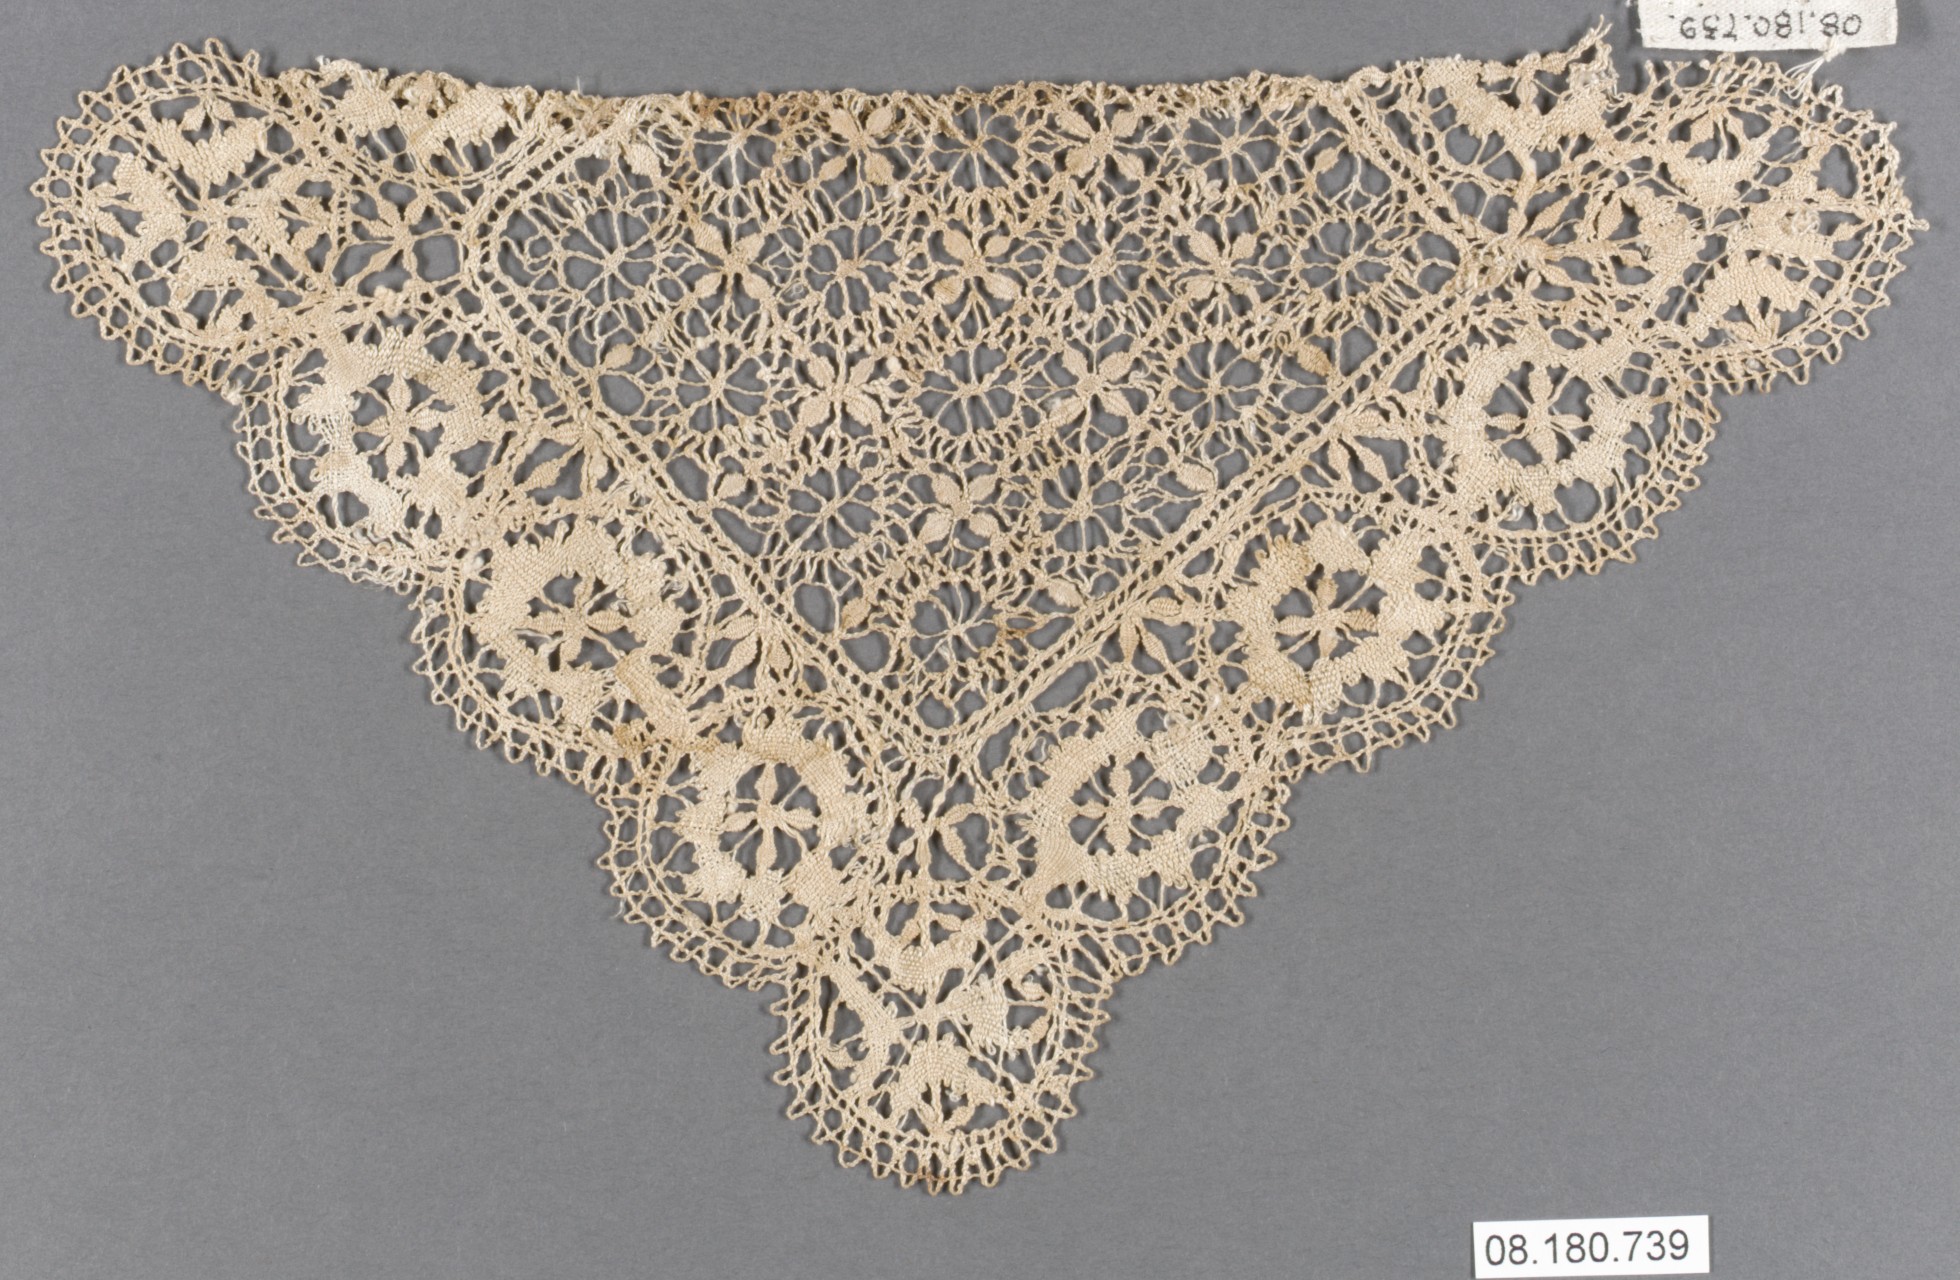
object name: fragment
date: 1801-1900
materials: silk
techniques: lace